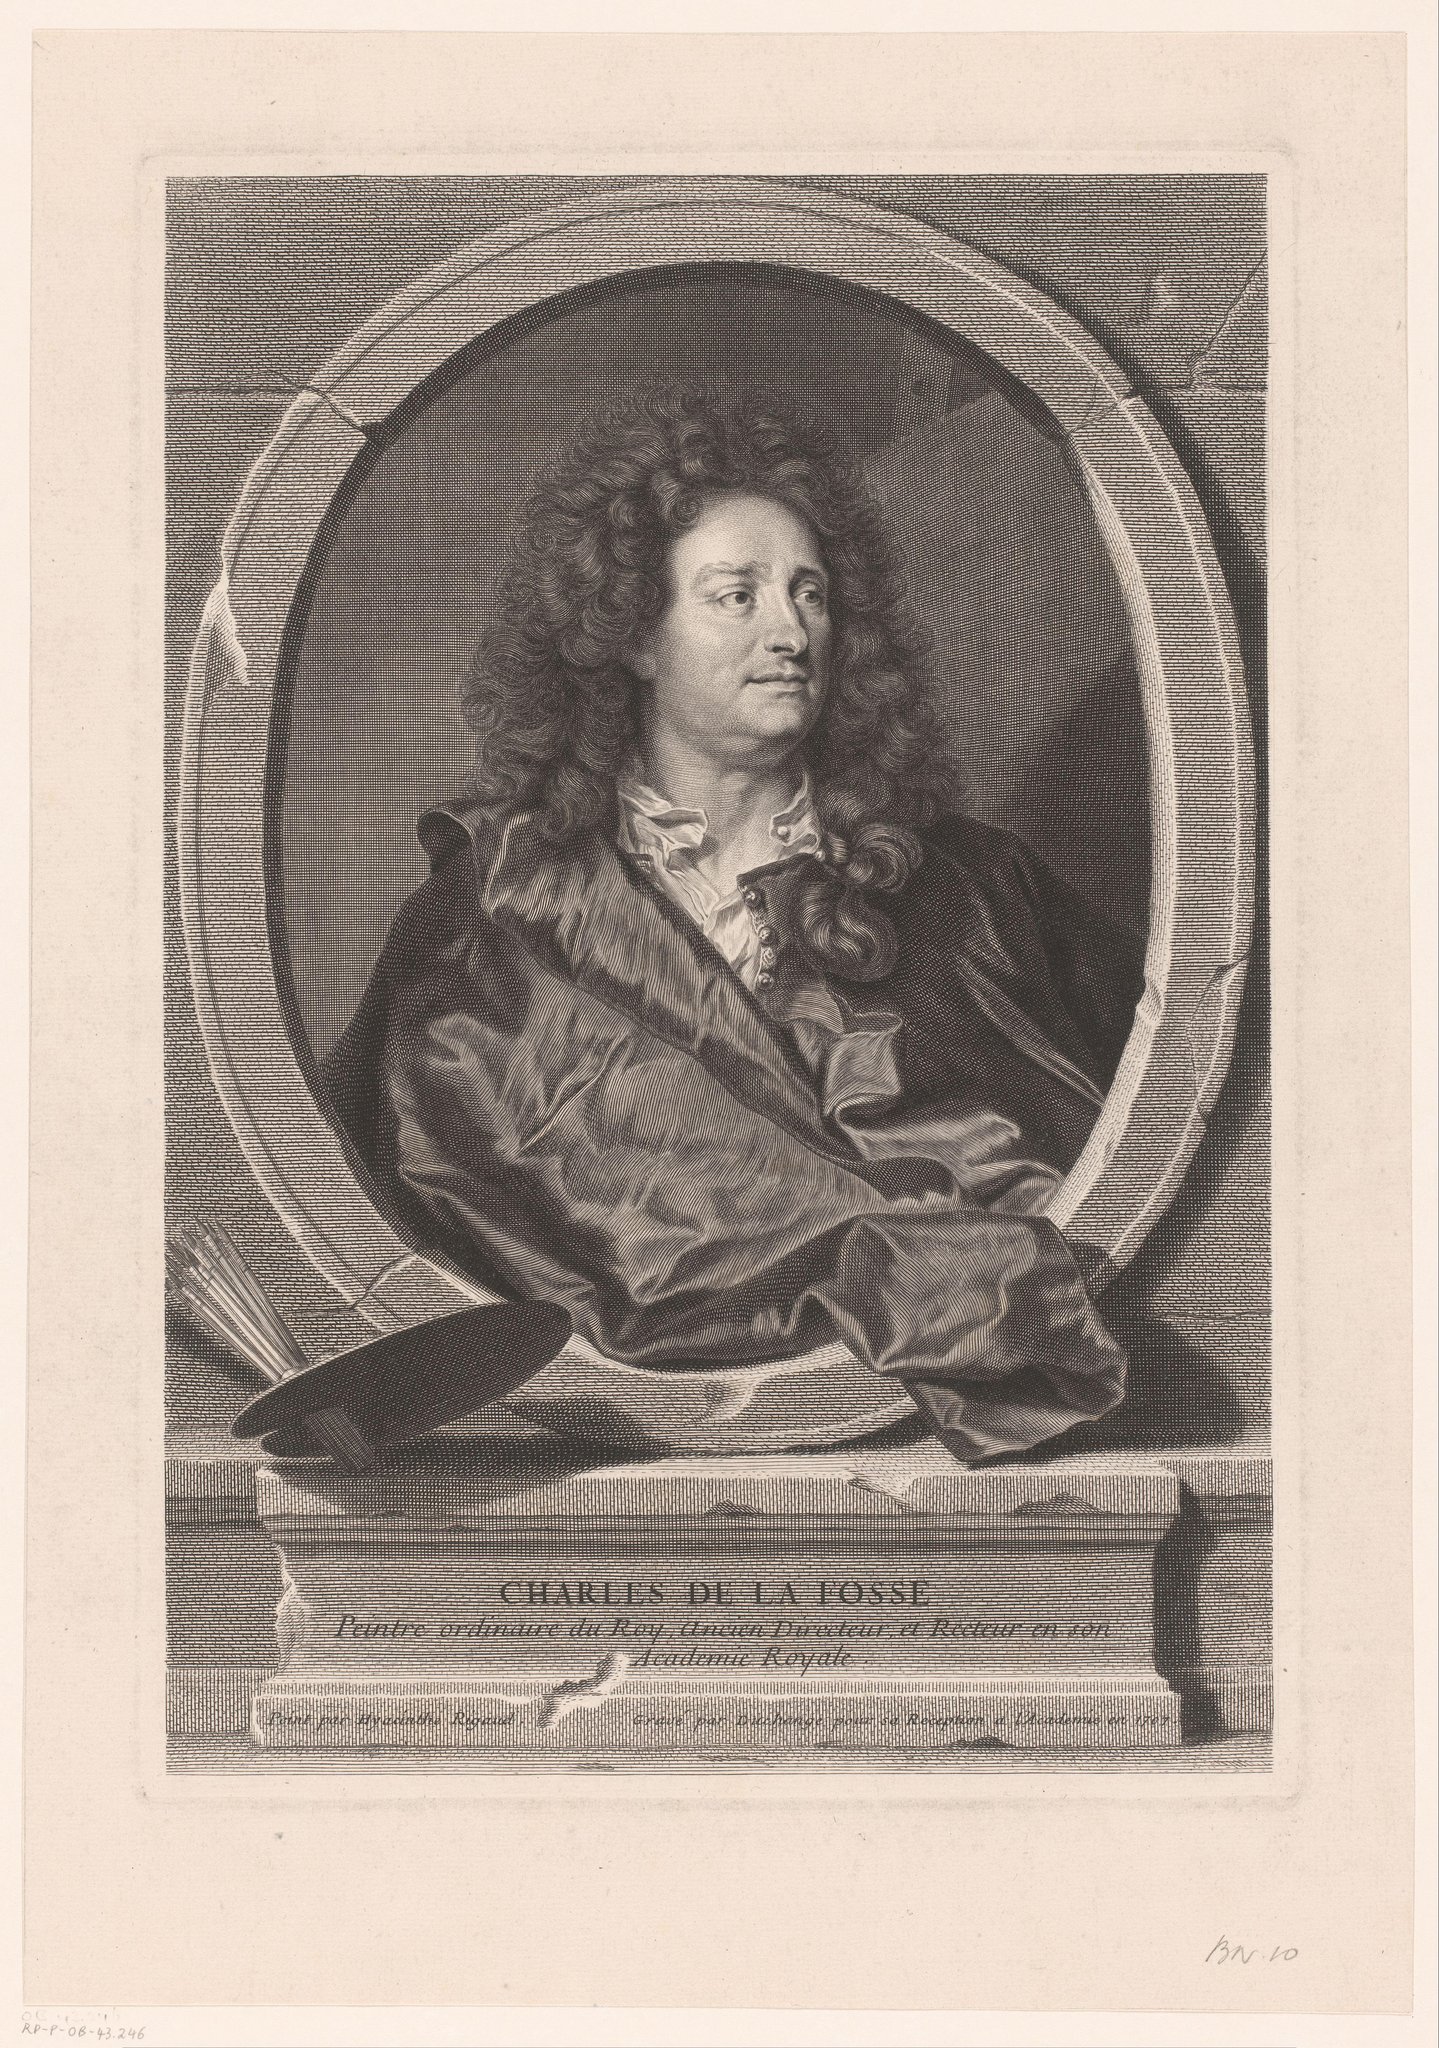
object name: print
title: Portret van Charles de La Fosse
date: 1707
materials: paper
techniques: engraving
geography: france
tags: ornament ~ medallion, portrait, self-portrait of painter, palette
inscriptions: collector's mark: Lugt 240